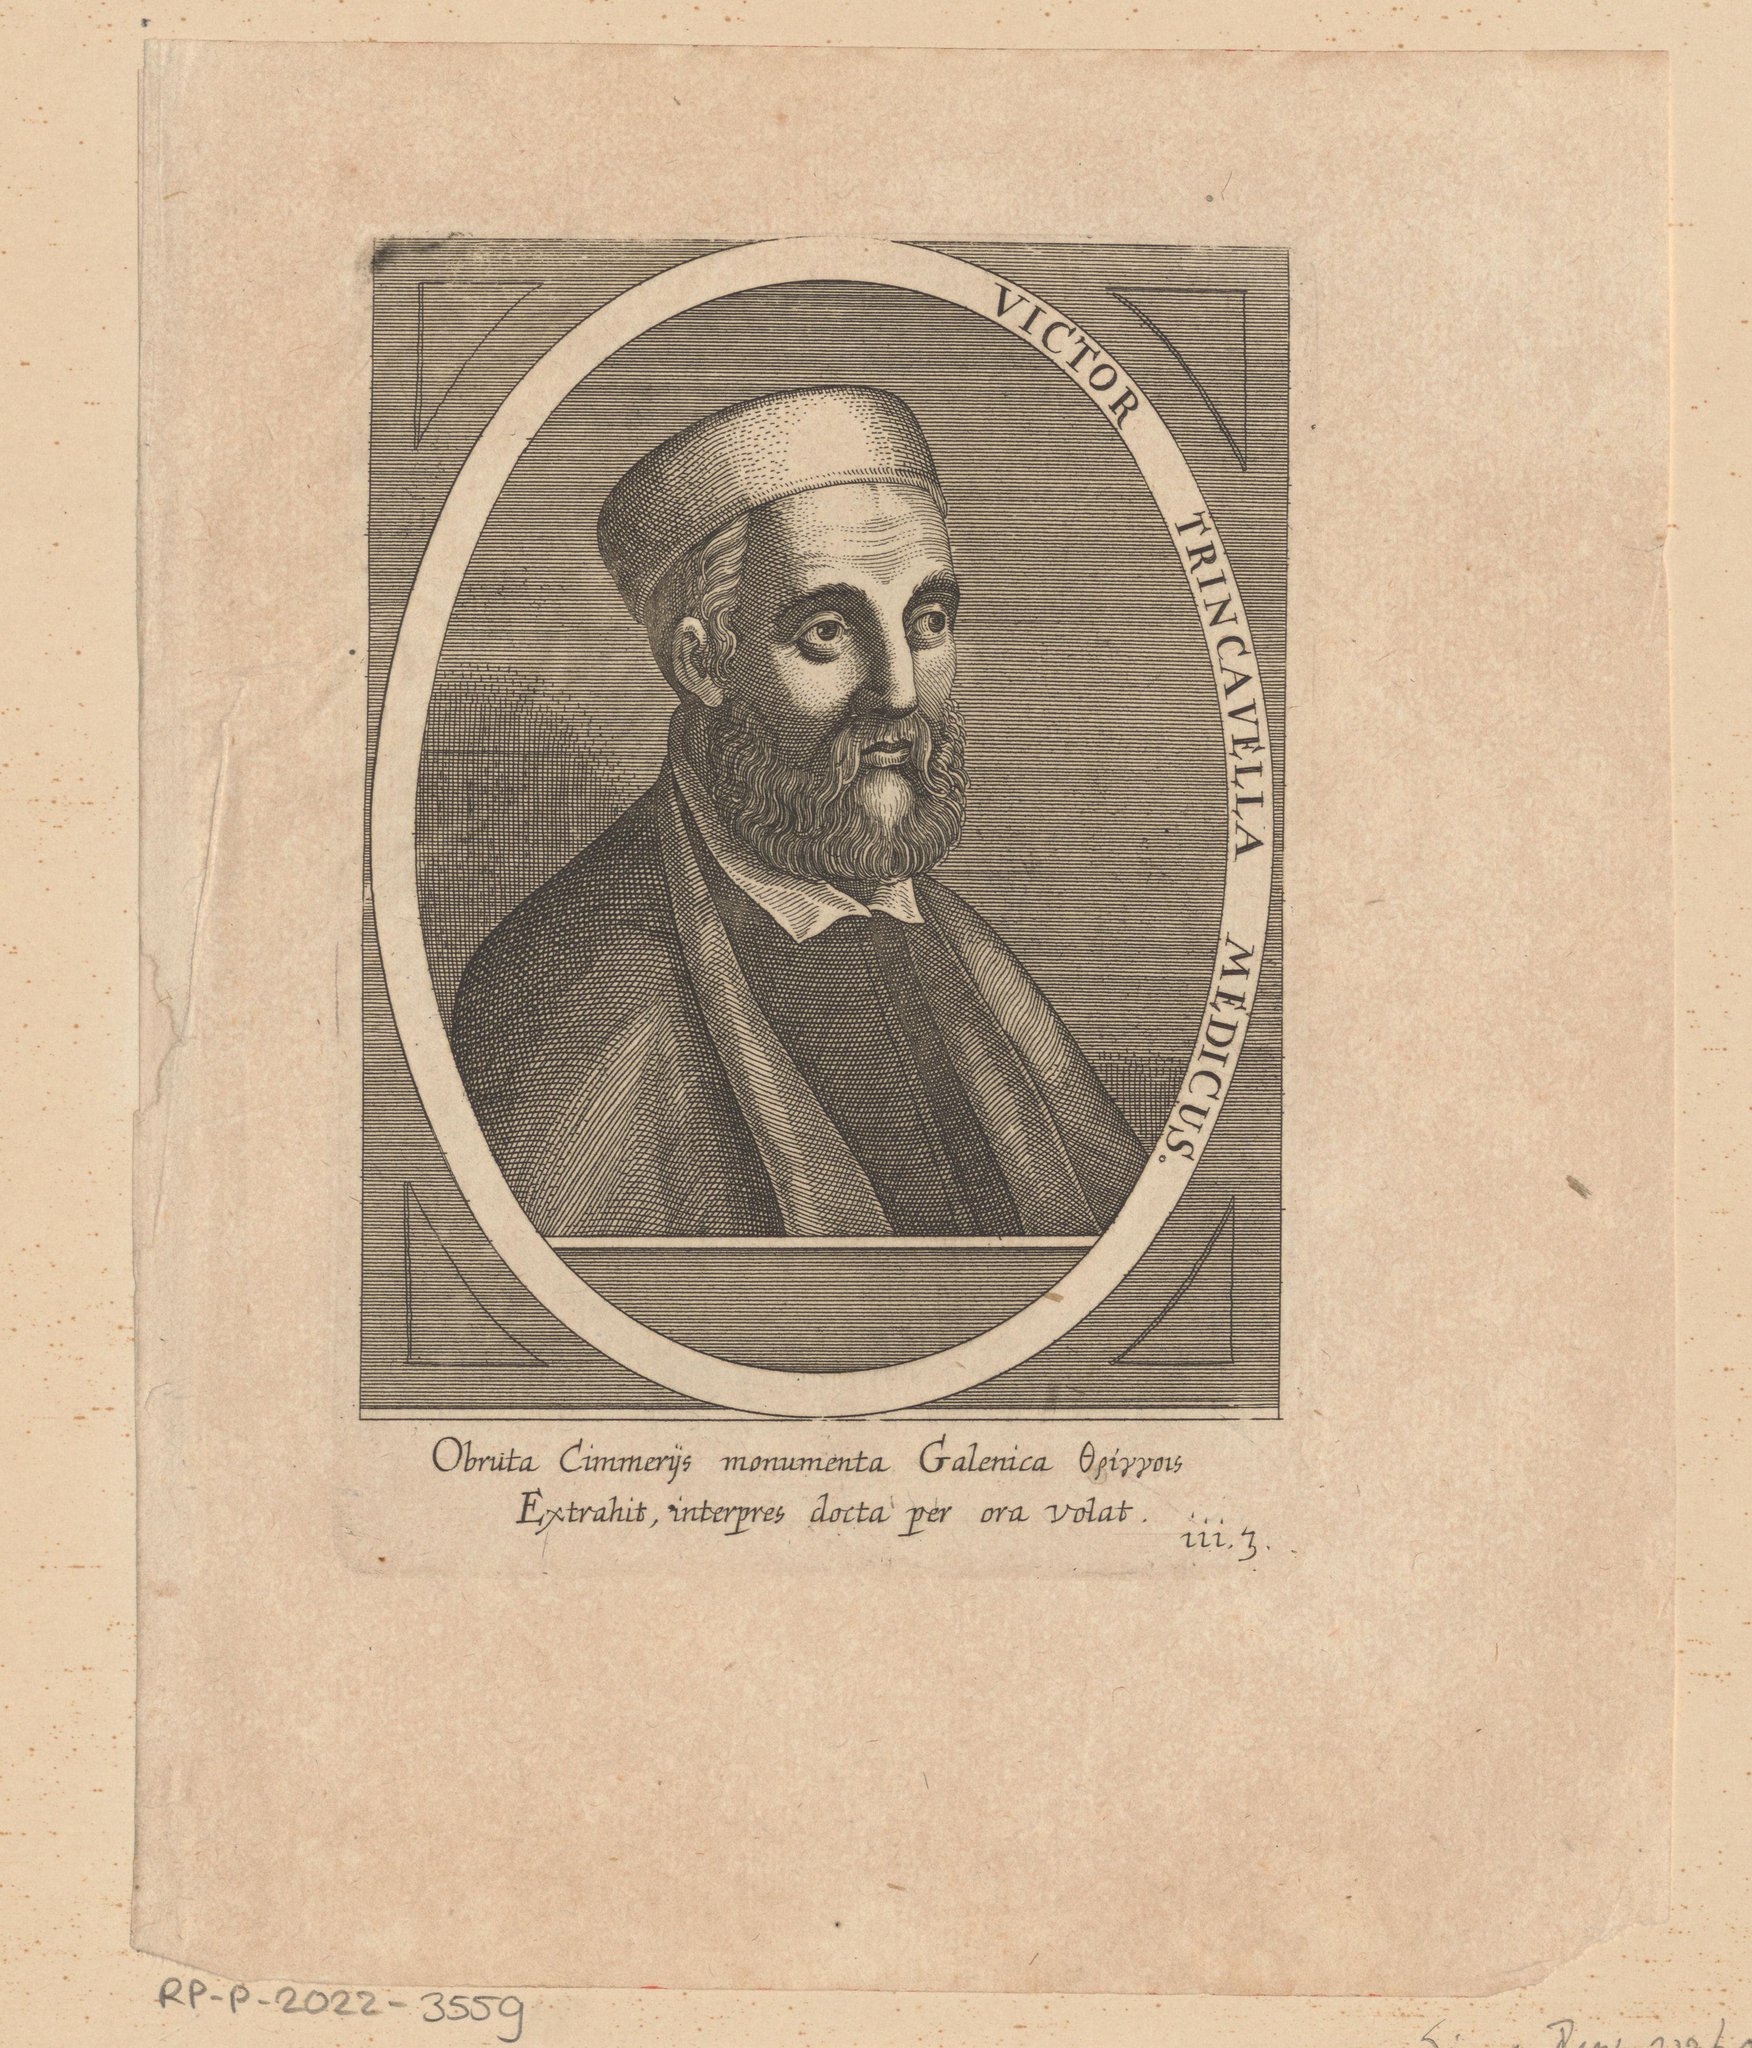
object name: print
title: Portretten van geleerden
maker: clemens ammon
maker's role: print maker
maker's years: 1627-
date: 1652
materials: paper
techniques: engraving, etching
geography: germany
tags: scholar, philosopher, historical persons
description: Prent waarschijnlijk uit: Boissard, Jean Jacques. Bibliotheca chalcographica (...) Frankfurt am Main: Johannes Ammon, 1652, dl. 8.